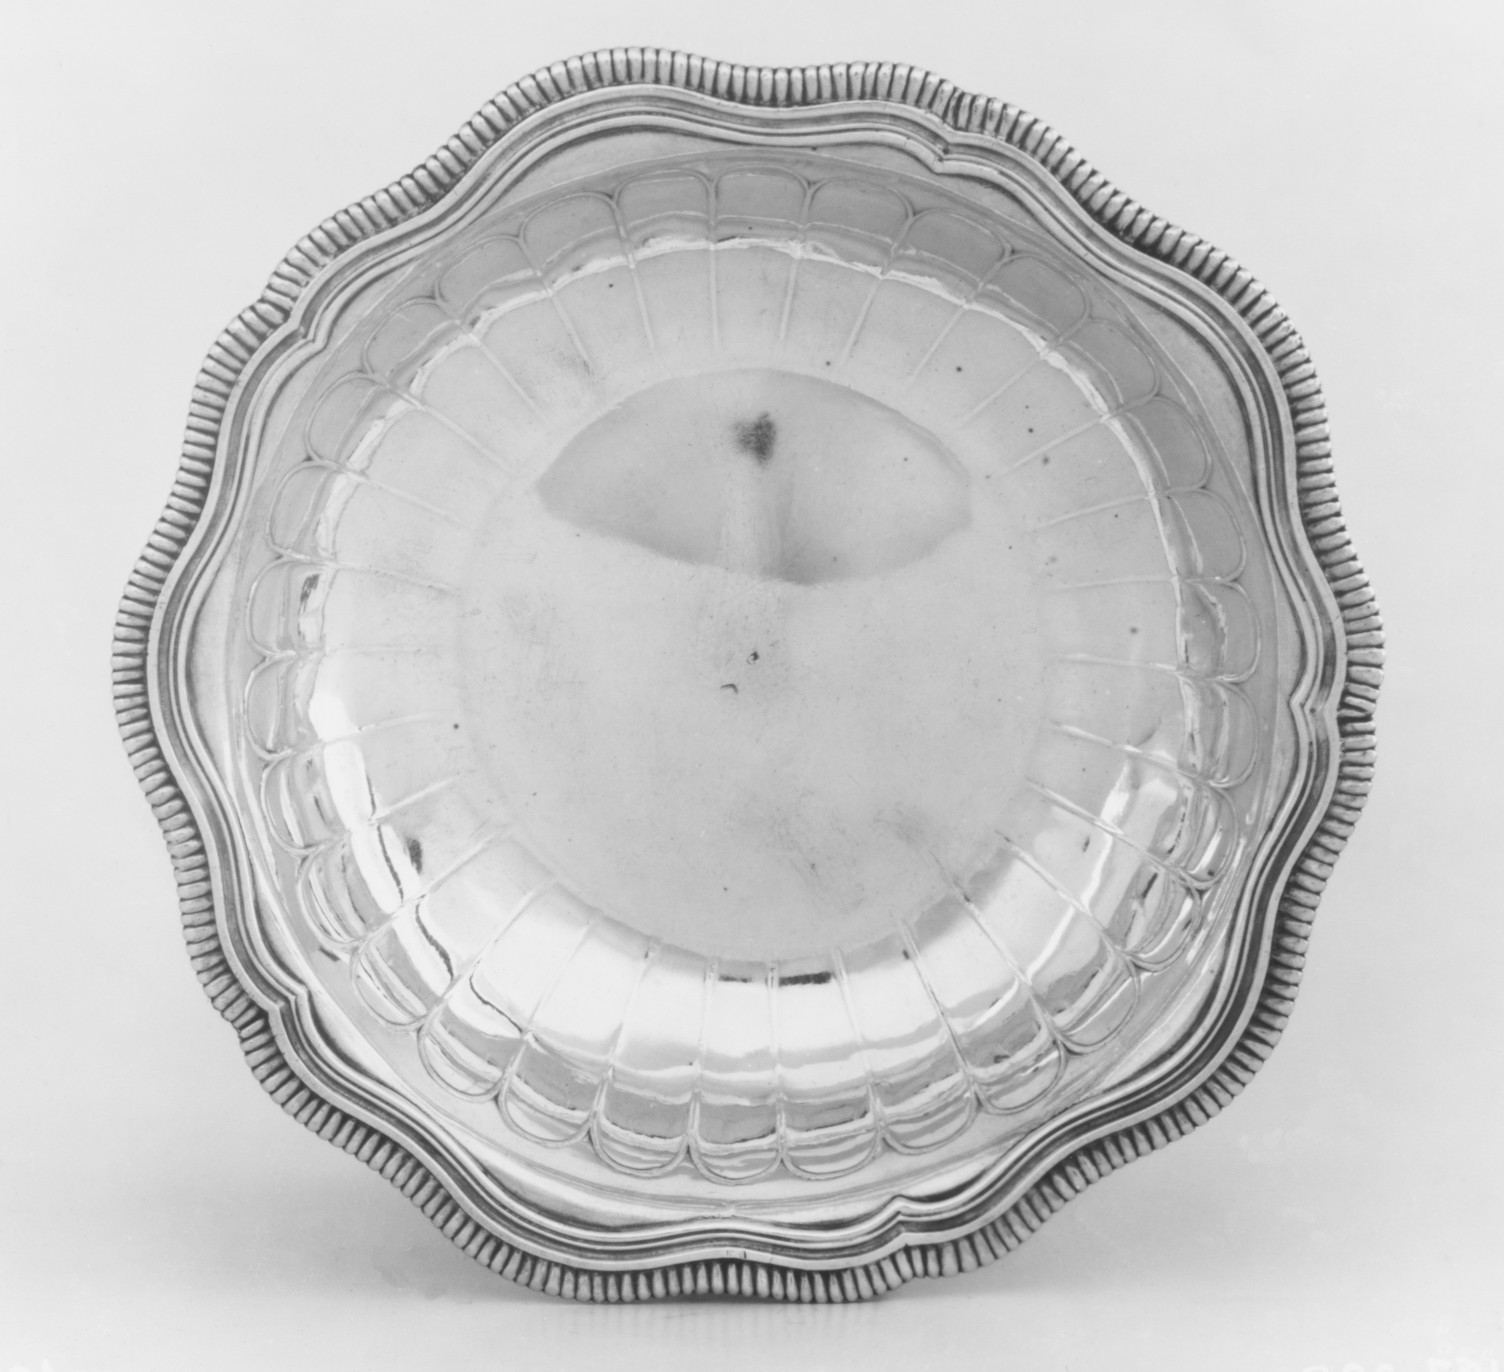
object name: dish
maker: i.b.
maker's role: maker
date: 1729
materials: silver